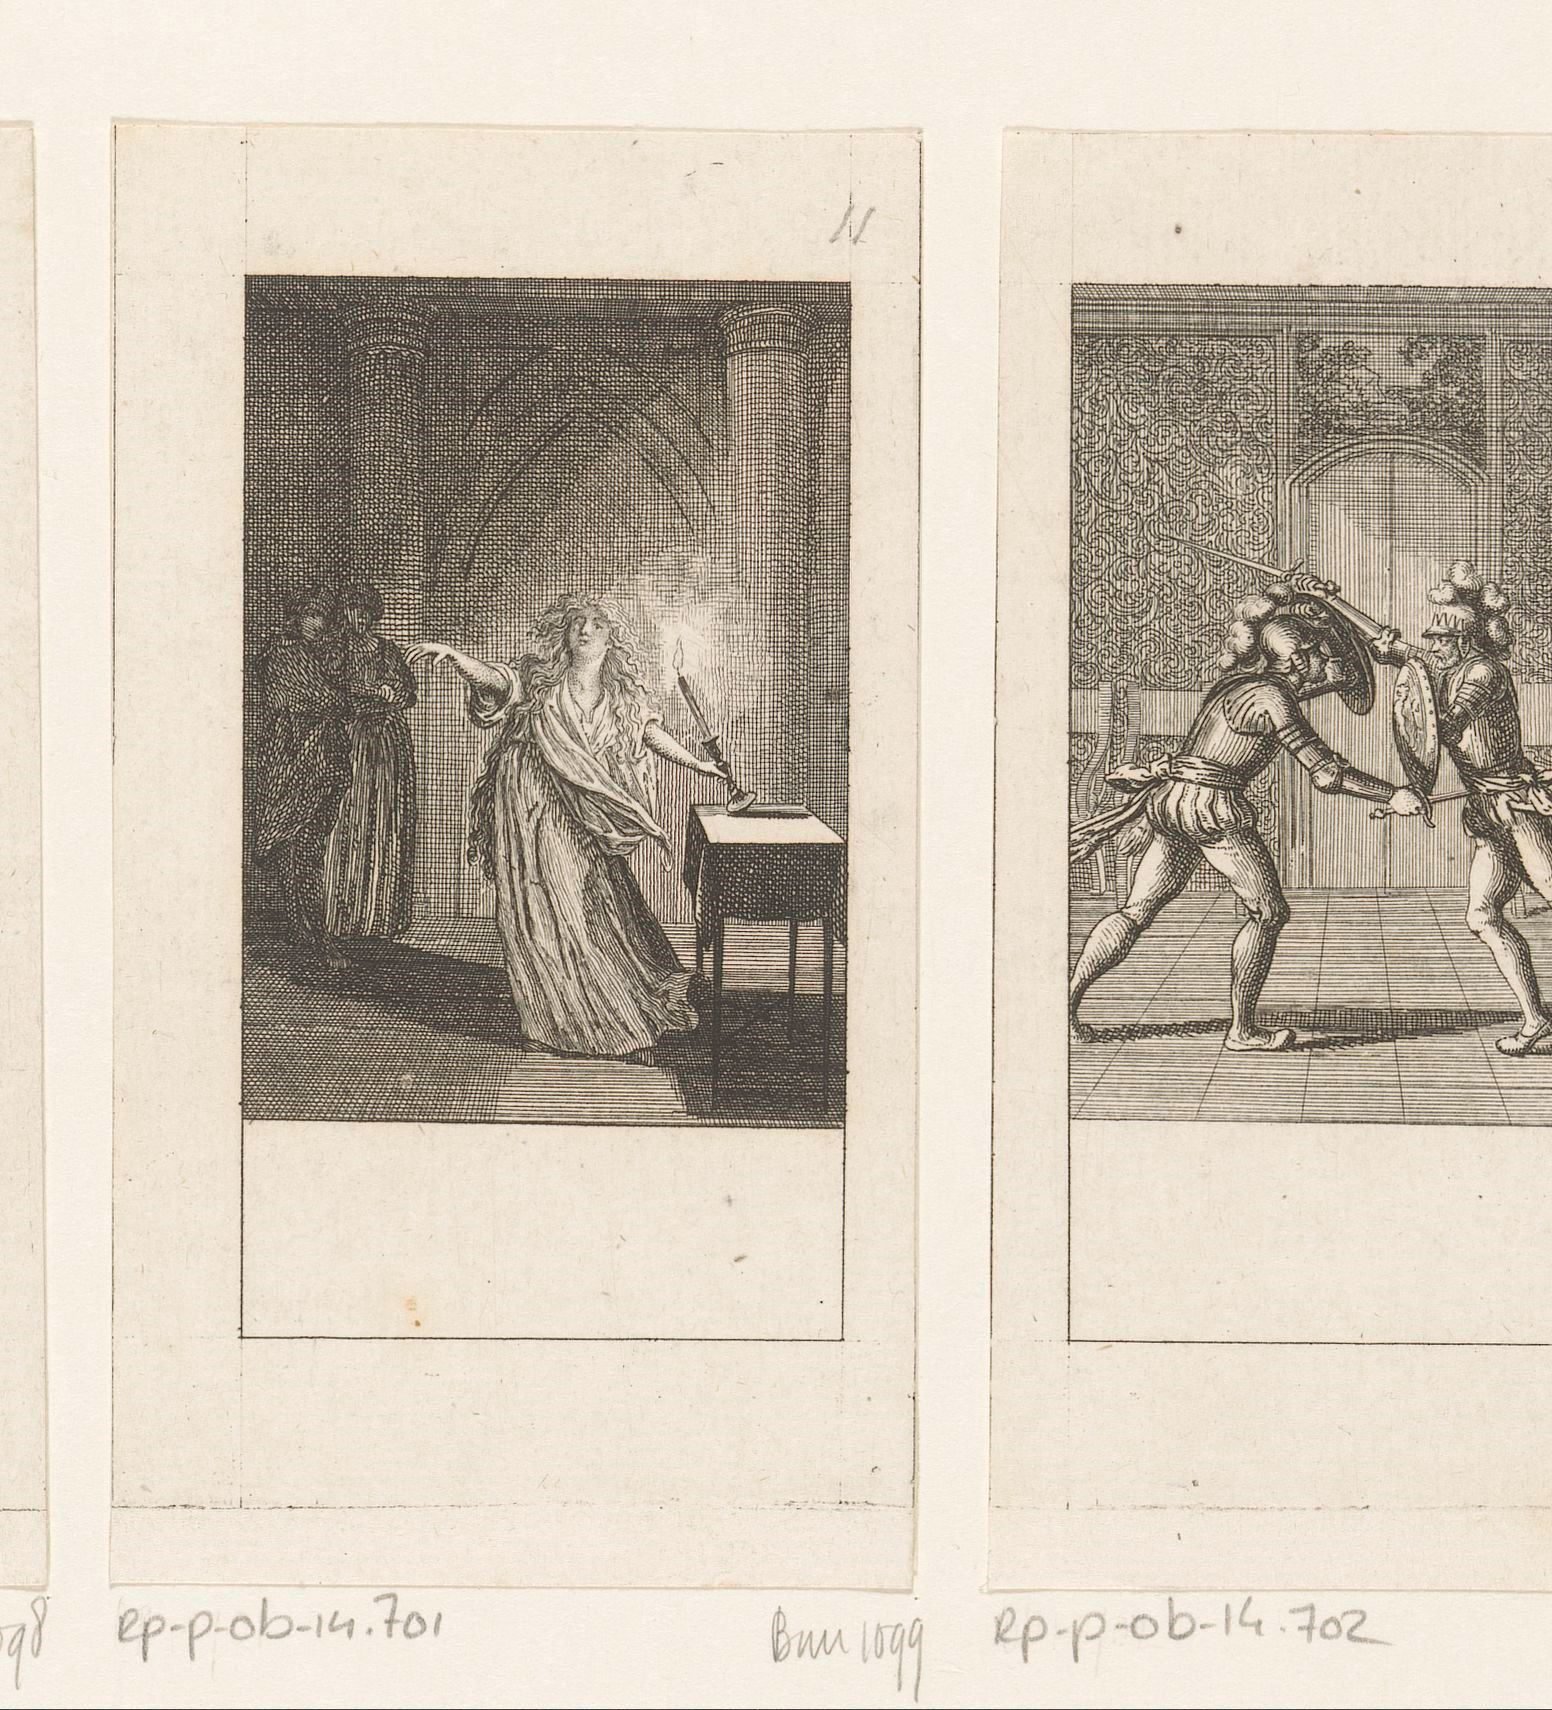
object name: print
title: Lady macbeth aan het slaapwandelen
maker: daniel nikolaus chodowiecki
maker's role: draughtsman, print maker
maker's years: 1726-1801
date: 1784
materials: paper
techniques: etching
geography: berlin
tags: william shakespeare, literature, sleepwalking, candle, macbeth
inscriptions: collector's mark: Lugt 2228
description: Vervaardigd voor William Shakespeares 'Macbeth'. Latere staat gebruikt voor: Goettinger Taschen Calender vom Jahre 1785. Göttingen: Johann Christoph Dietrich, 1784.